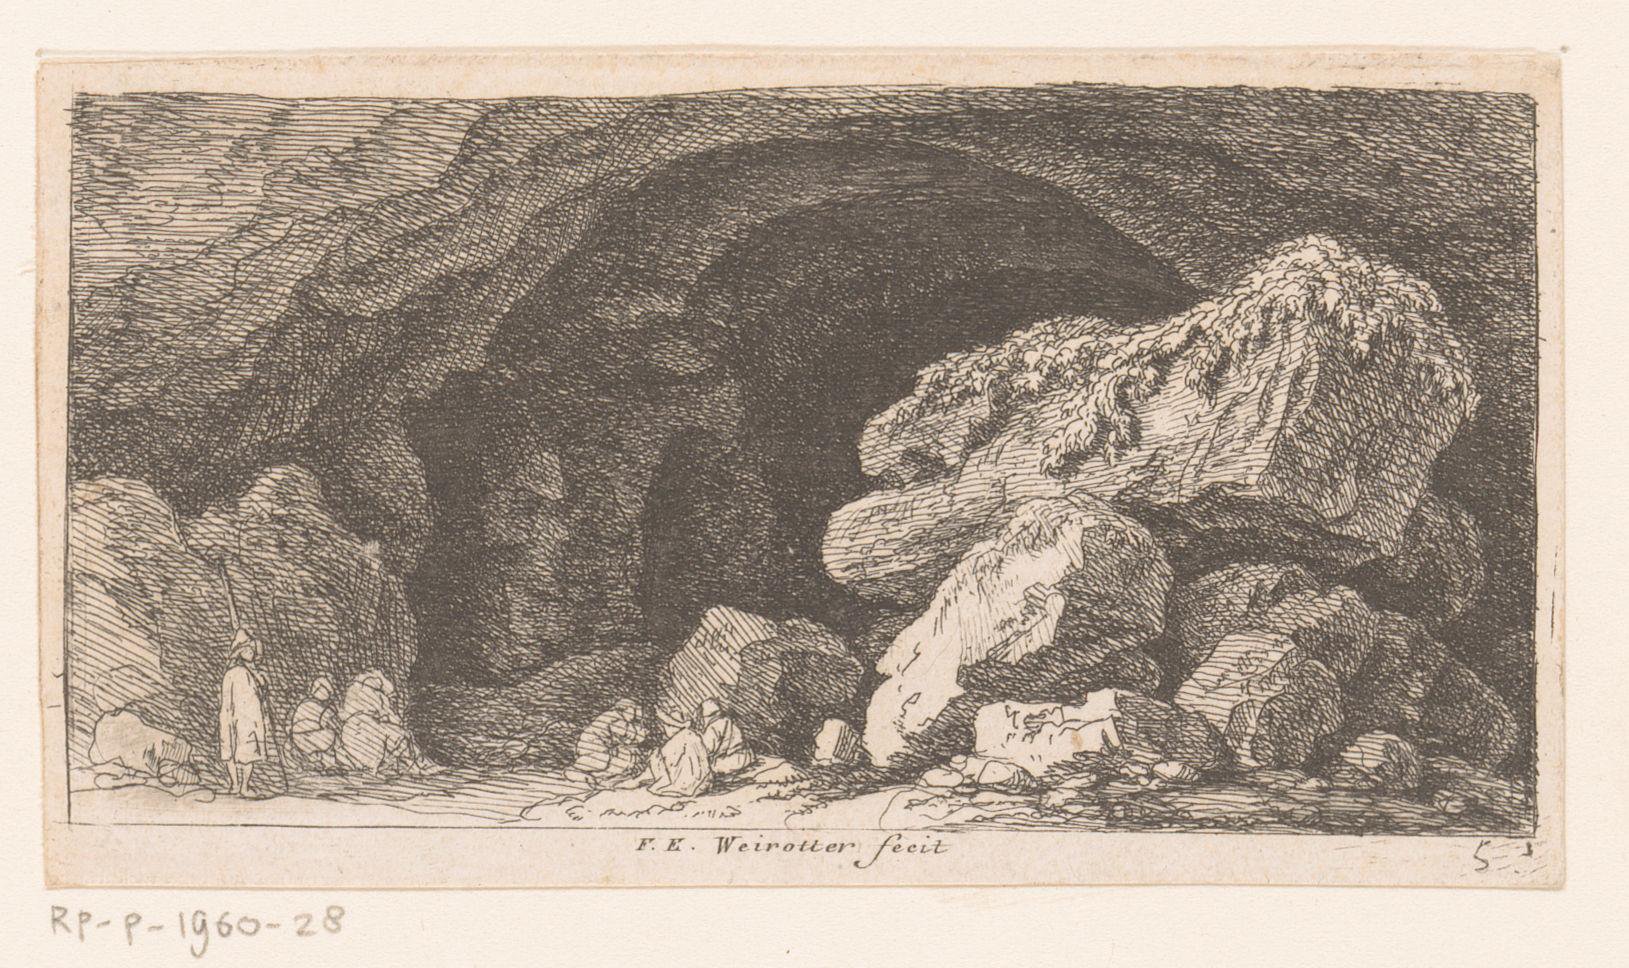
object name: print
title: Fünfte Folge von Unterschiedlichen Gegenden Alter Gebäude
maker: franz edmund weirotter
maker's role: draughtsman, painter, print maker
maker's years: 1733-1771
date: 1767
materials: paper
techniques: etching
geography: vienna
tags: (traveller) resting in the open air, cave, grotto, rock-formations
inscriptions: collector's mark: Lugt 2228, collector's mark: Lugt 2760